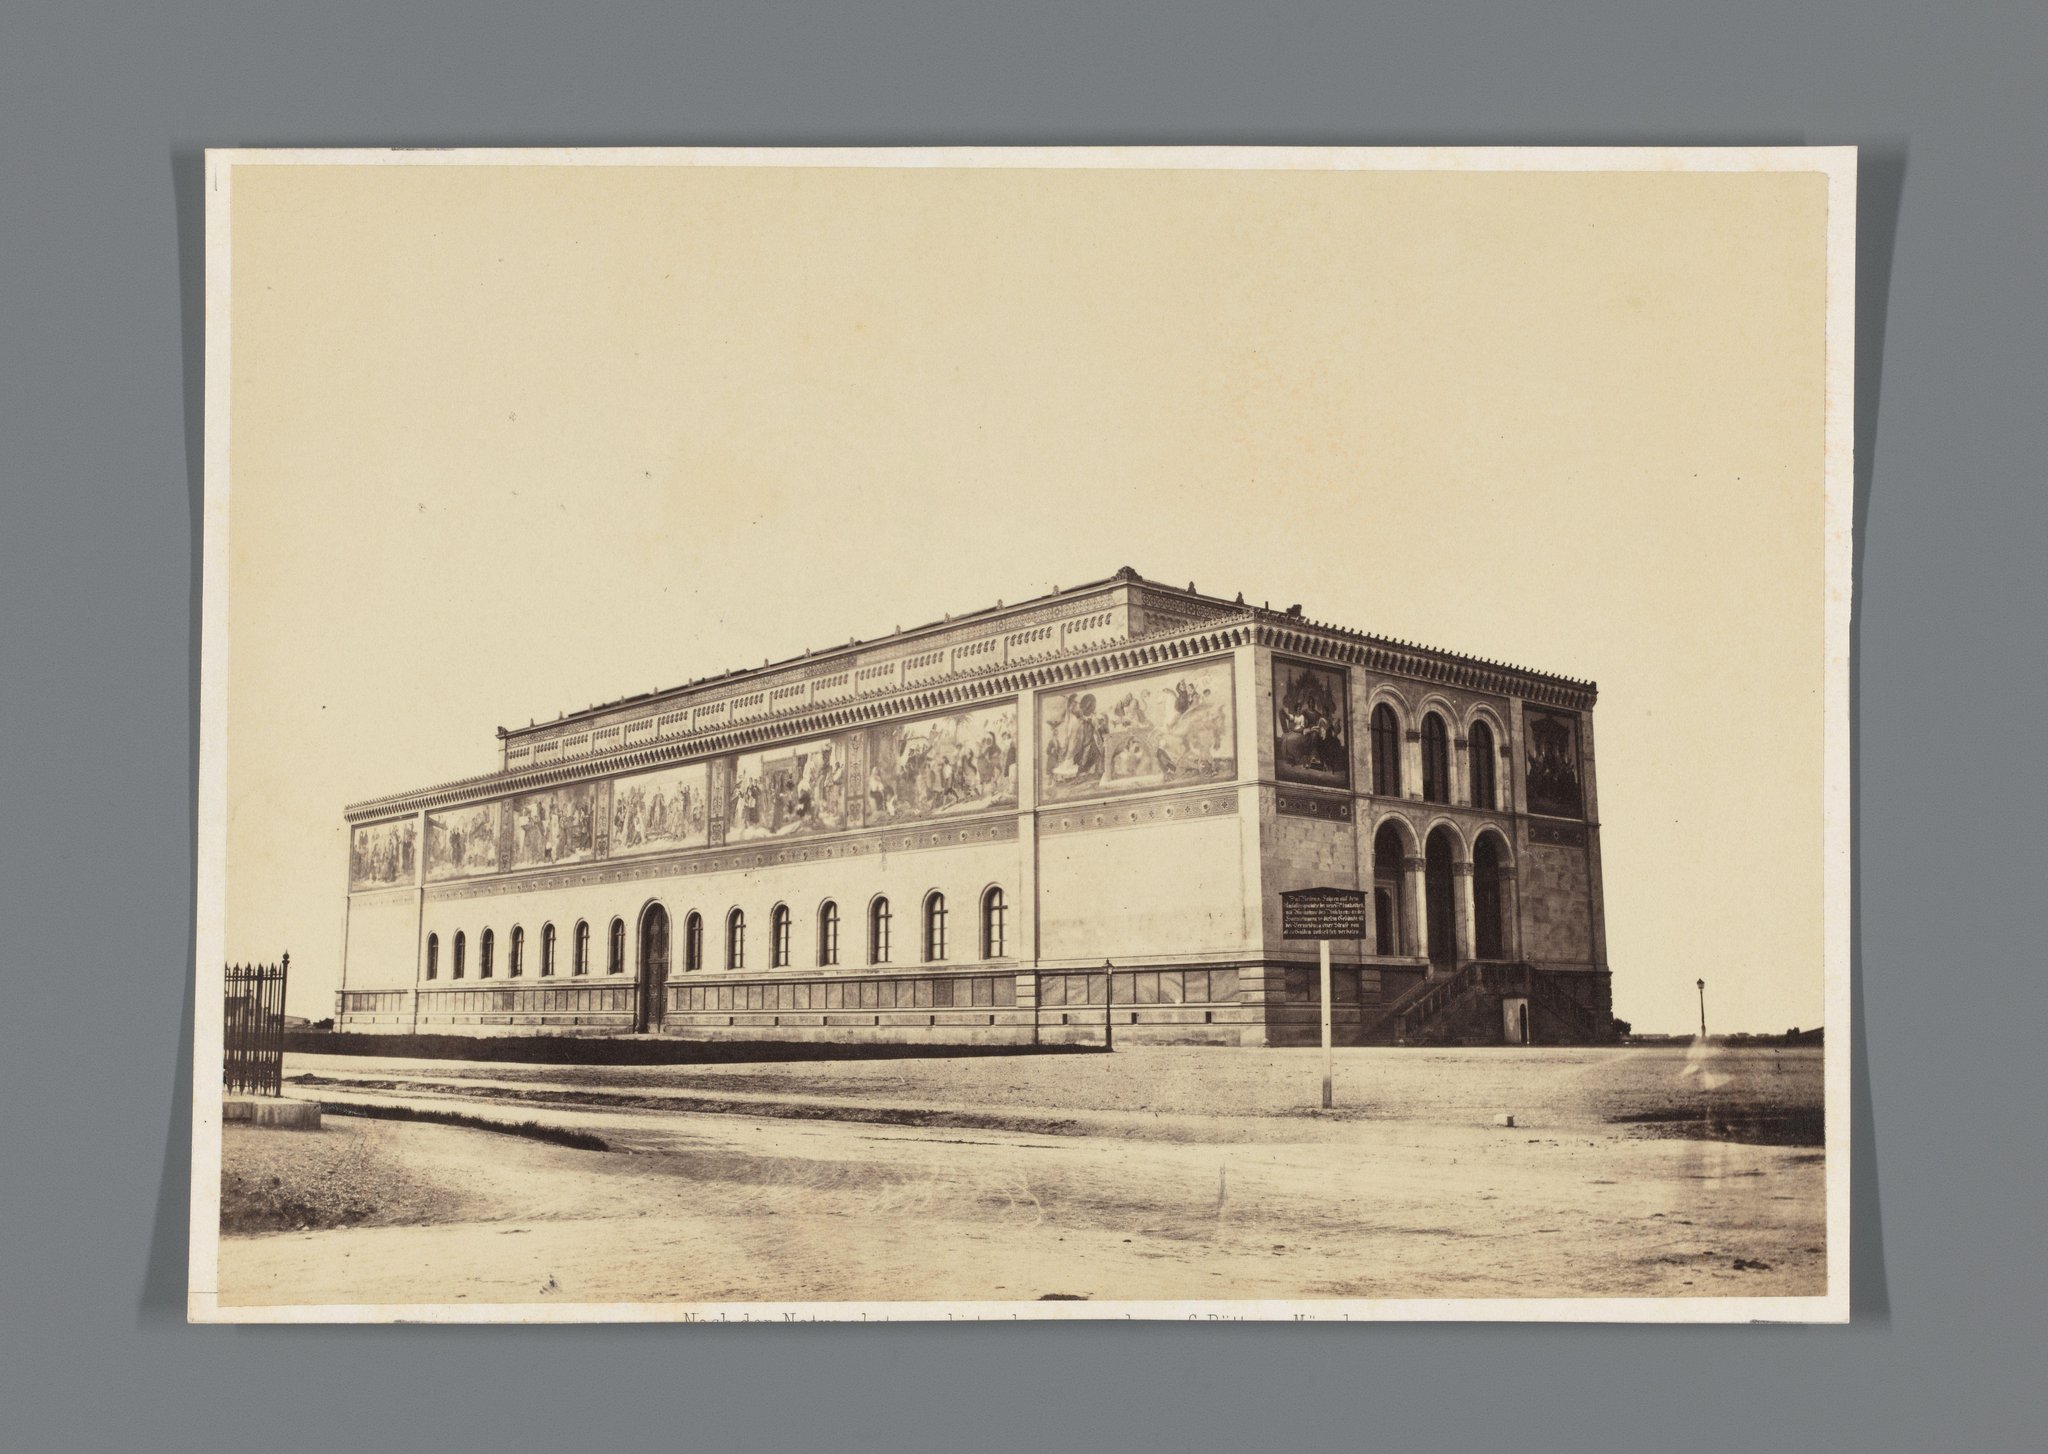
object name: photograph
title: Neue Pinakothek, München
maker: Anonymous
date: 1850-1900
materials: photographic support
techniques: albumen print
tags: neue pinakothek